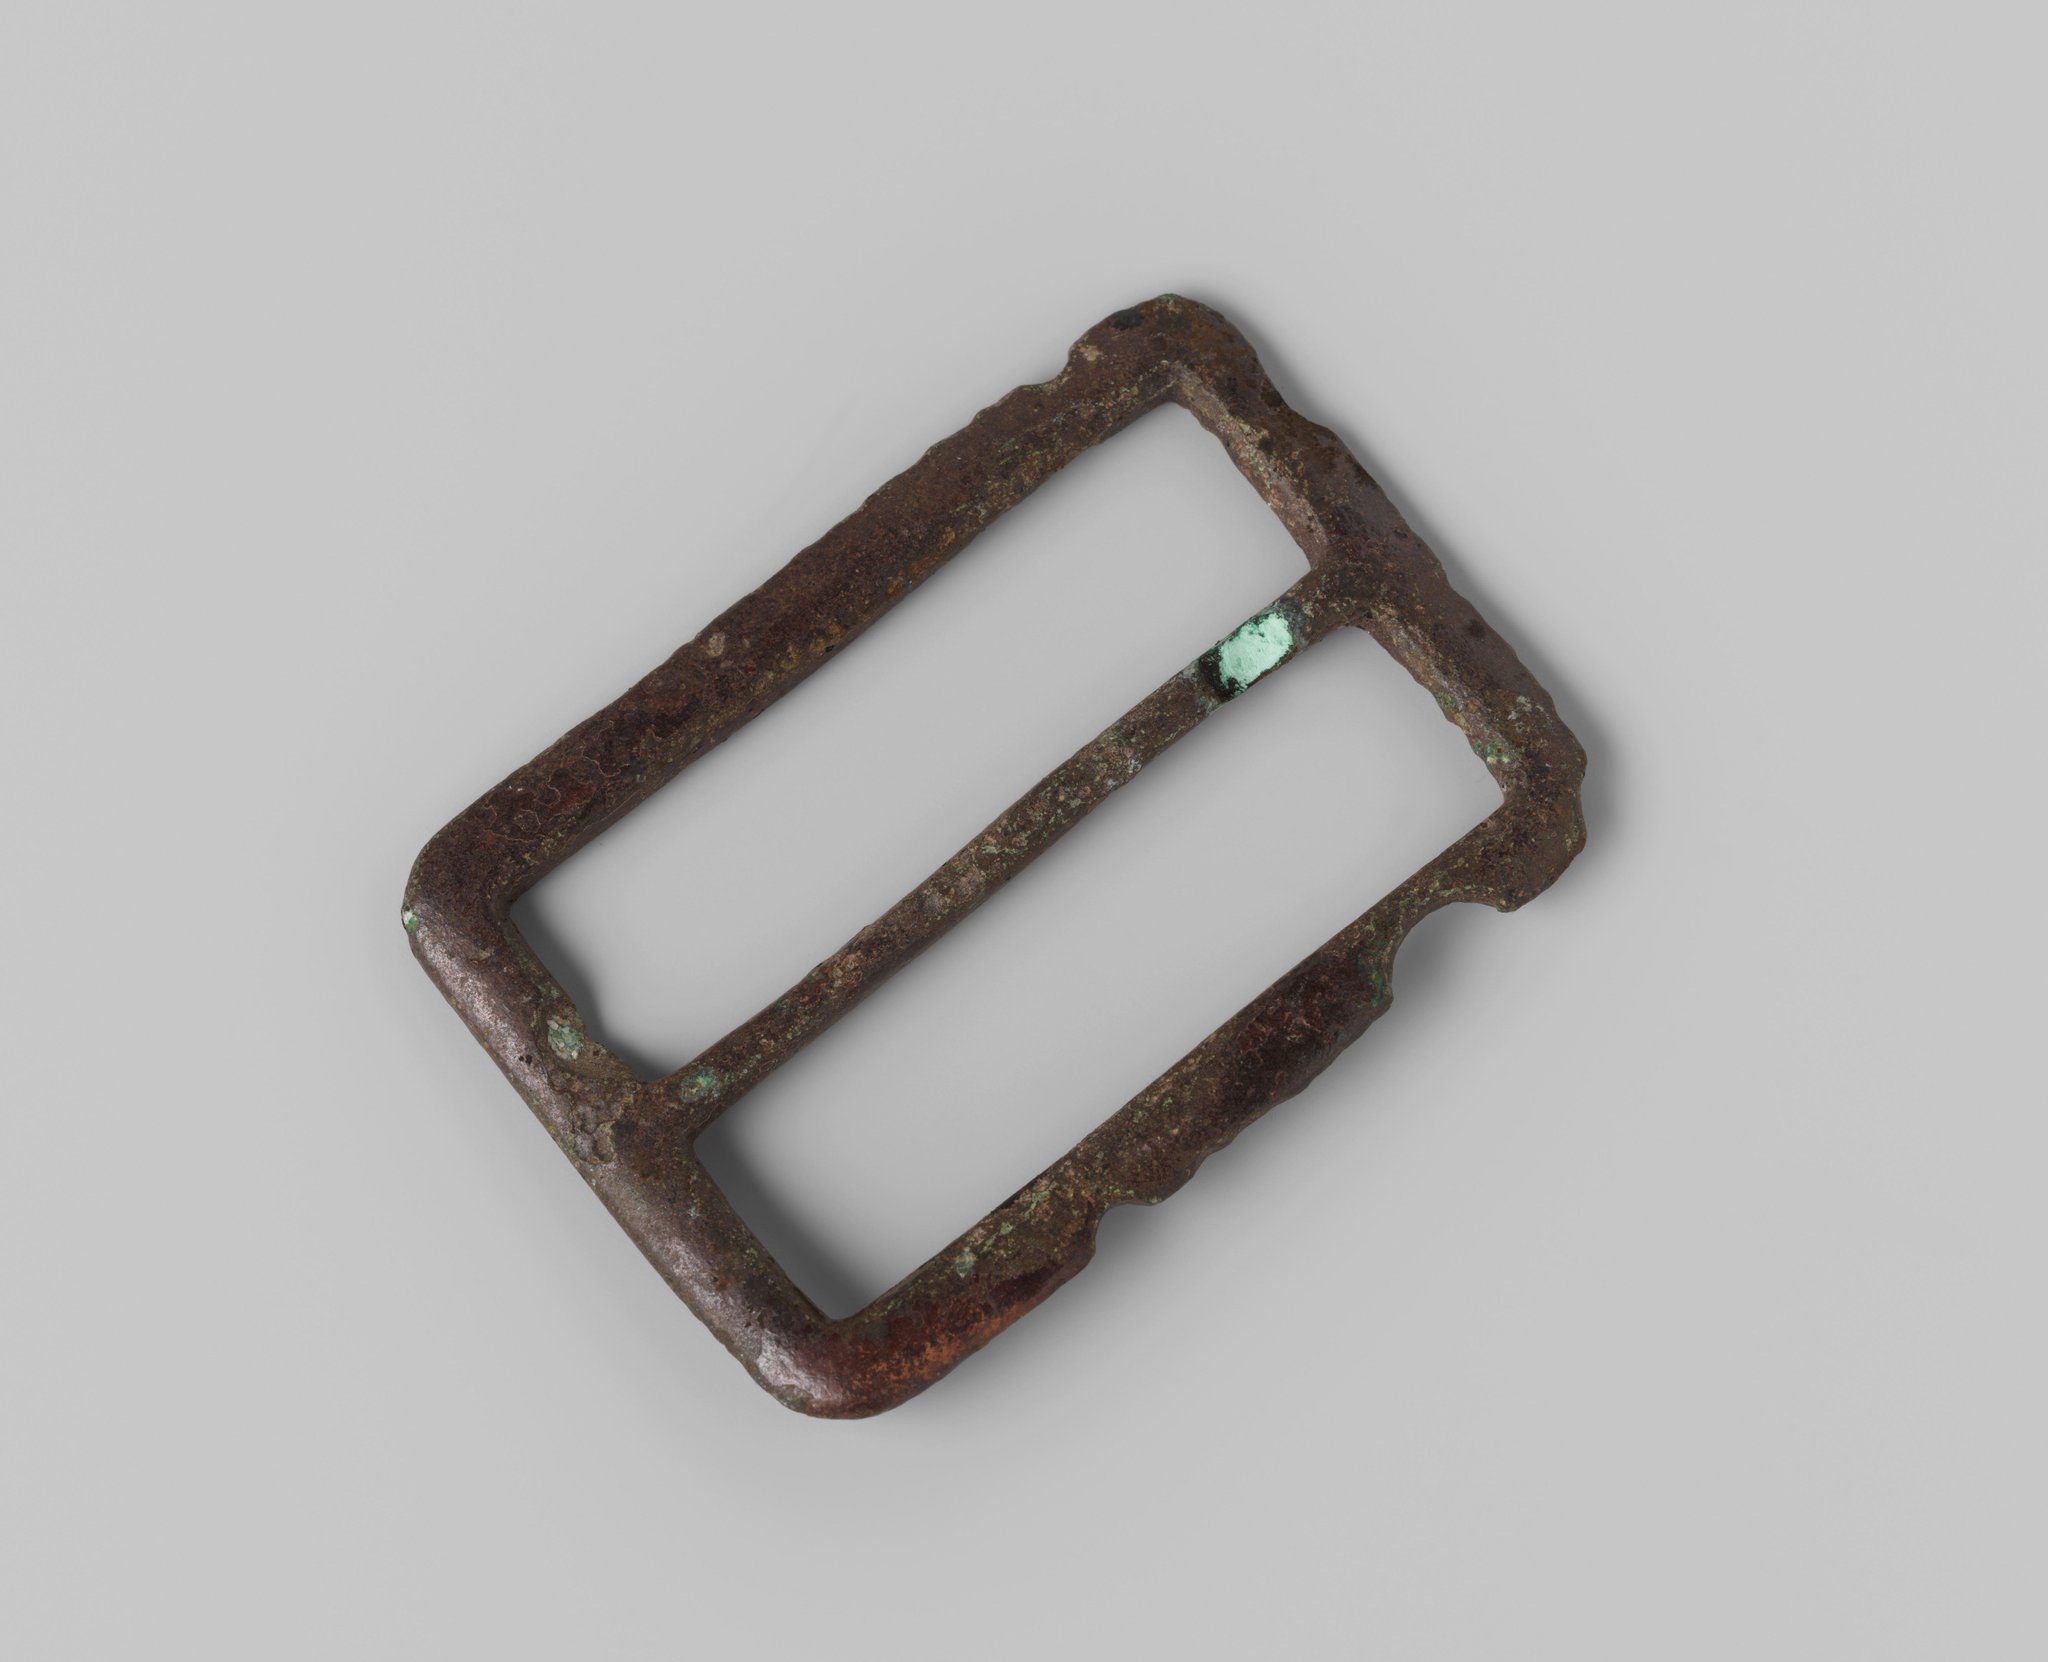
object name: belt buckle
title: Riemgesp uit het wrak van de Oost-Indiëvaarder Hollandia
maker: Anonymous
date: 1700-1743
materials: copper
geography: netherlands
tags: verenigde oostindische compagnie, hollandia (schip), annet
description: Rectangular, ring with spindle, id. NG 1980-27H2796, belt buckle.